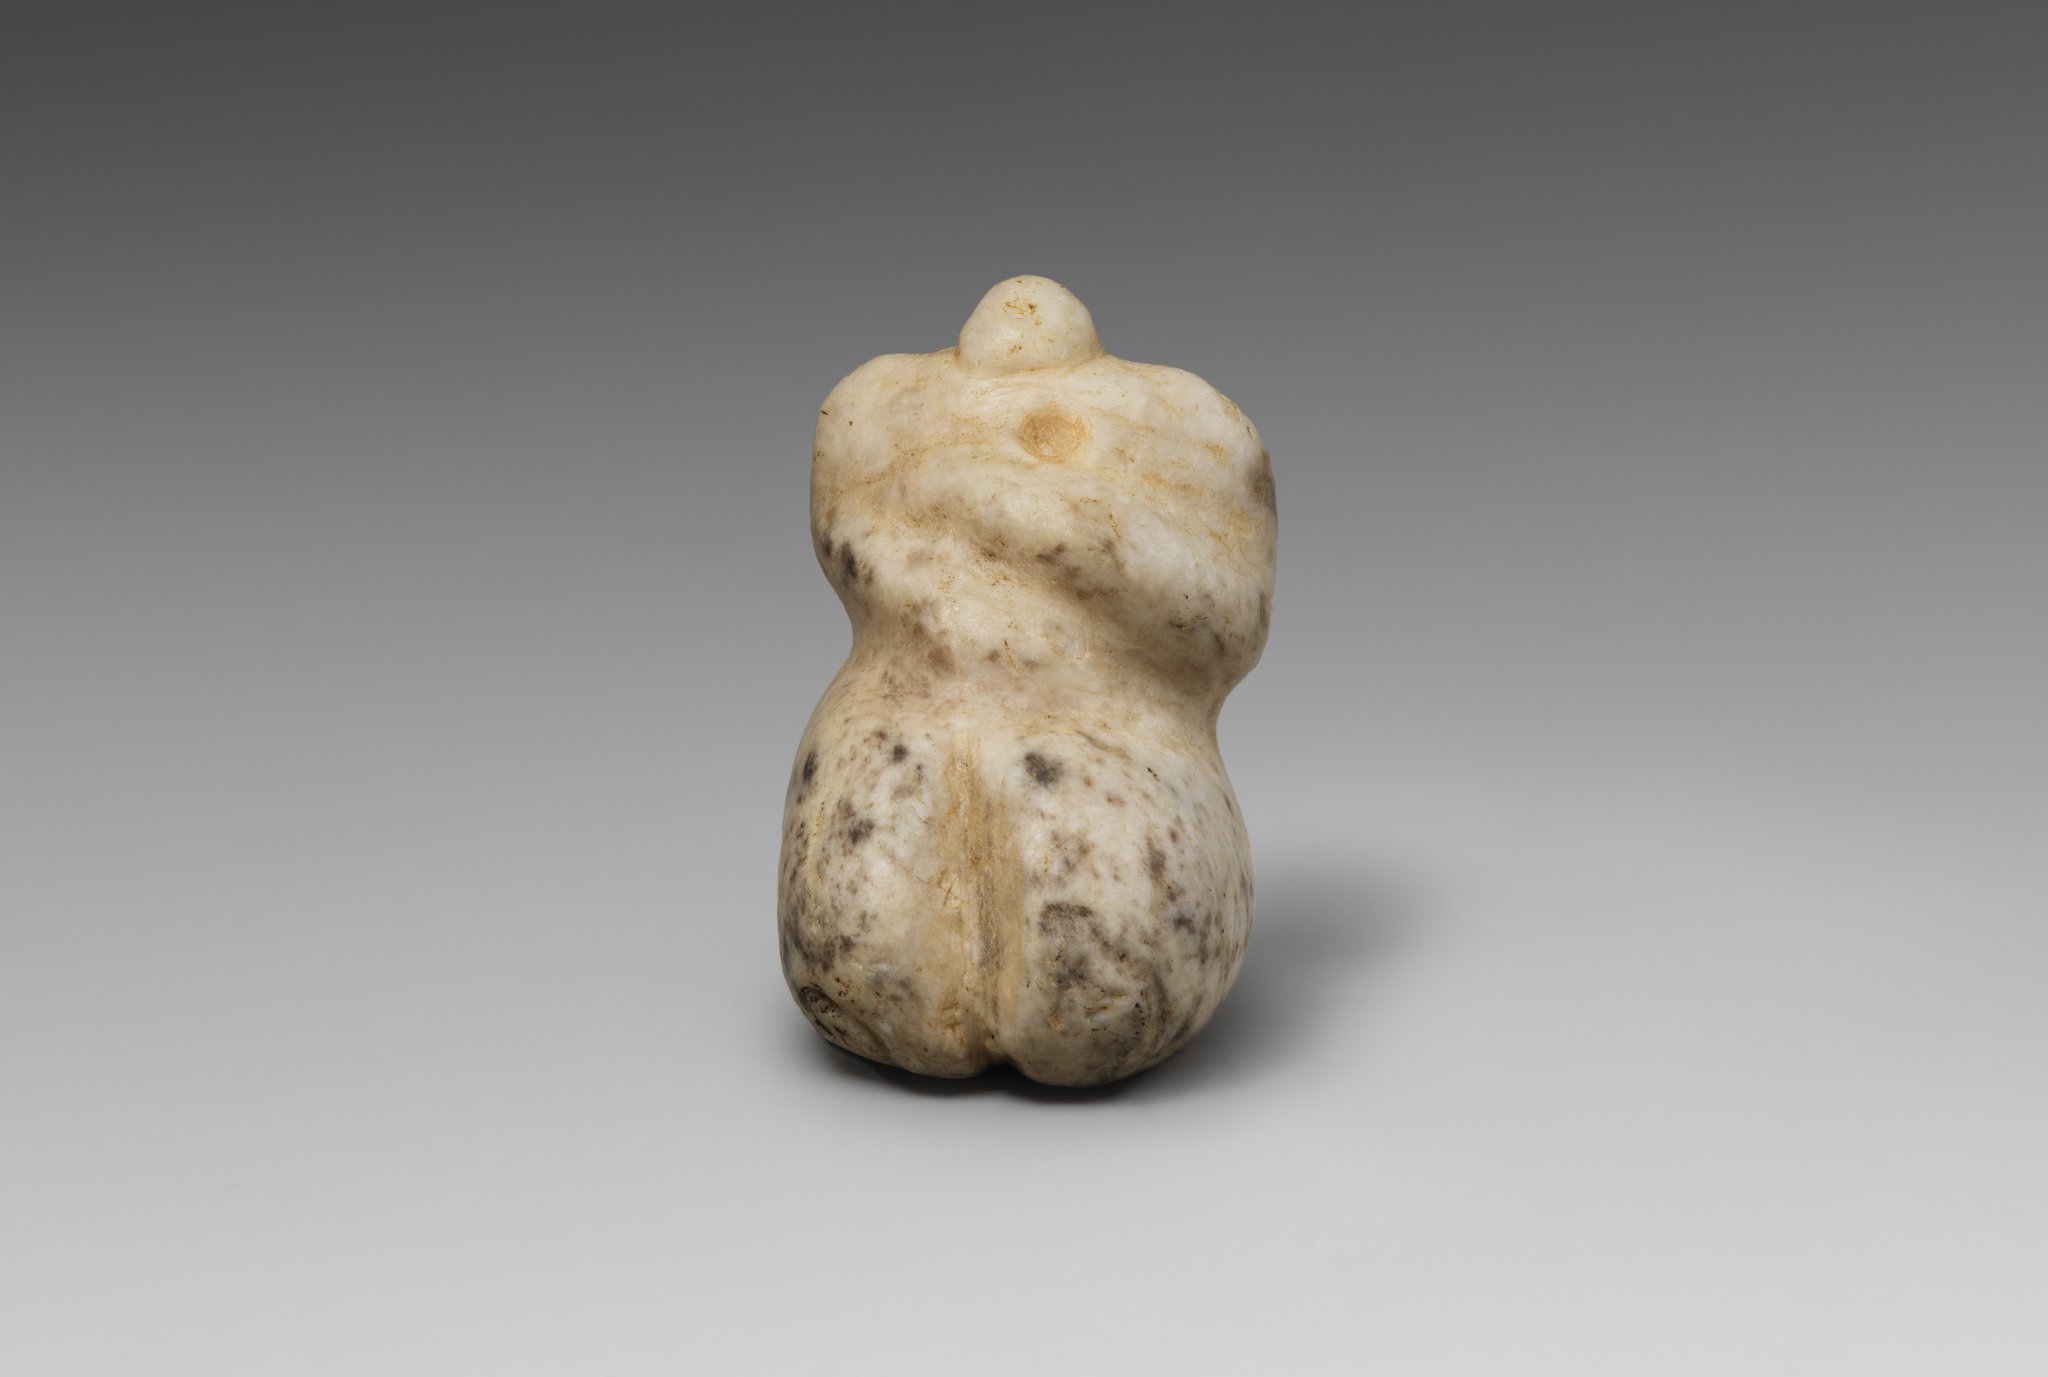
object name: sculpture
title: Seated figure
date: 7333-7001 BCE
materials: limestone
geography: syria